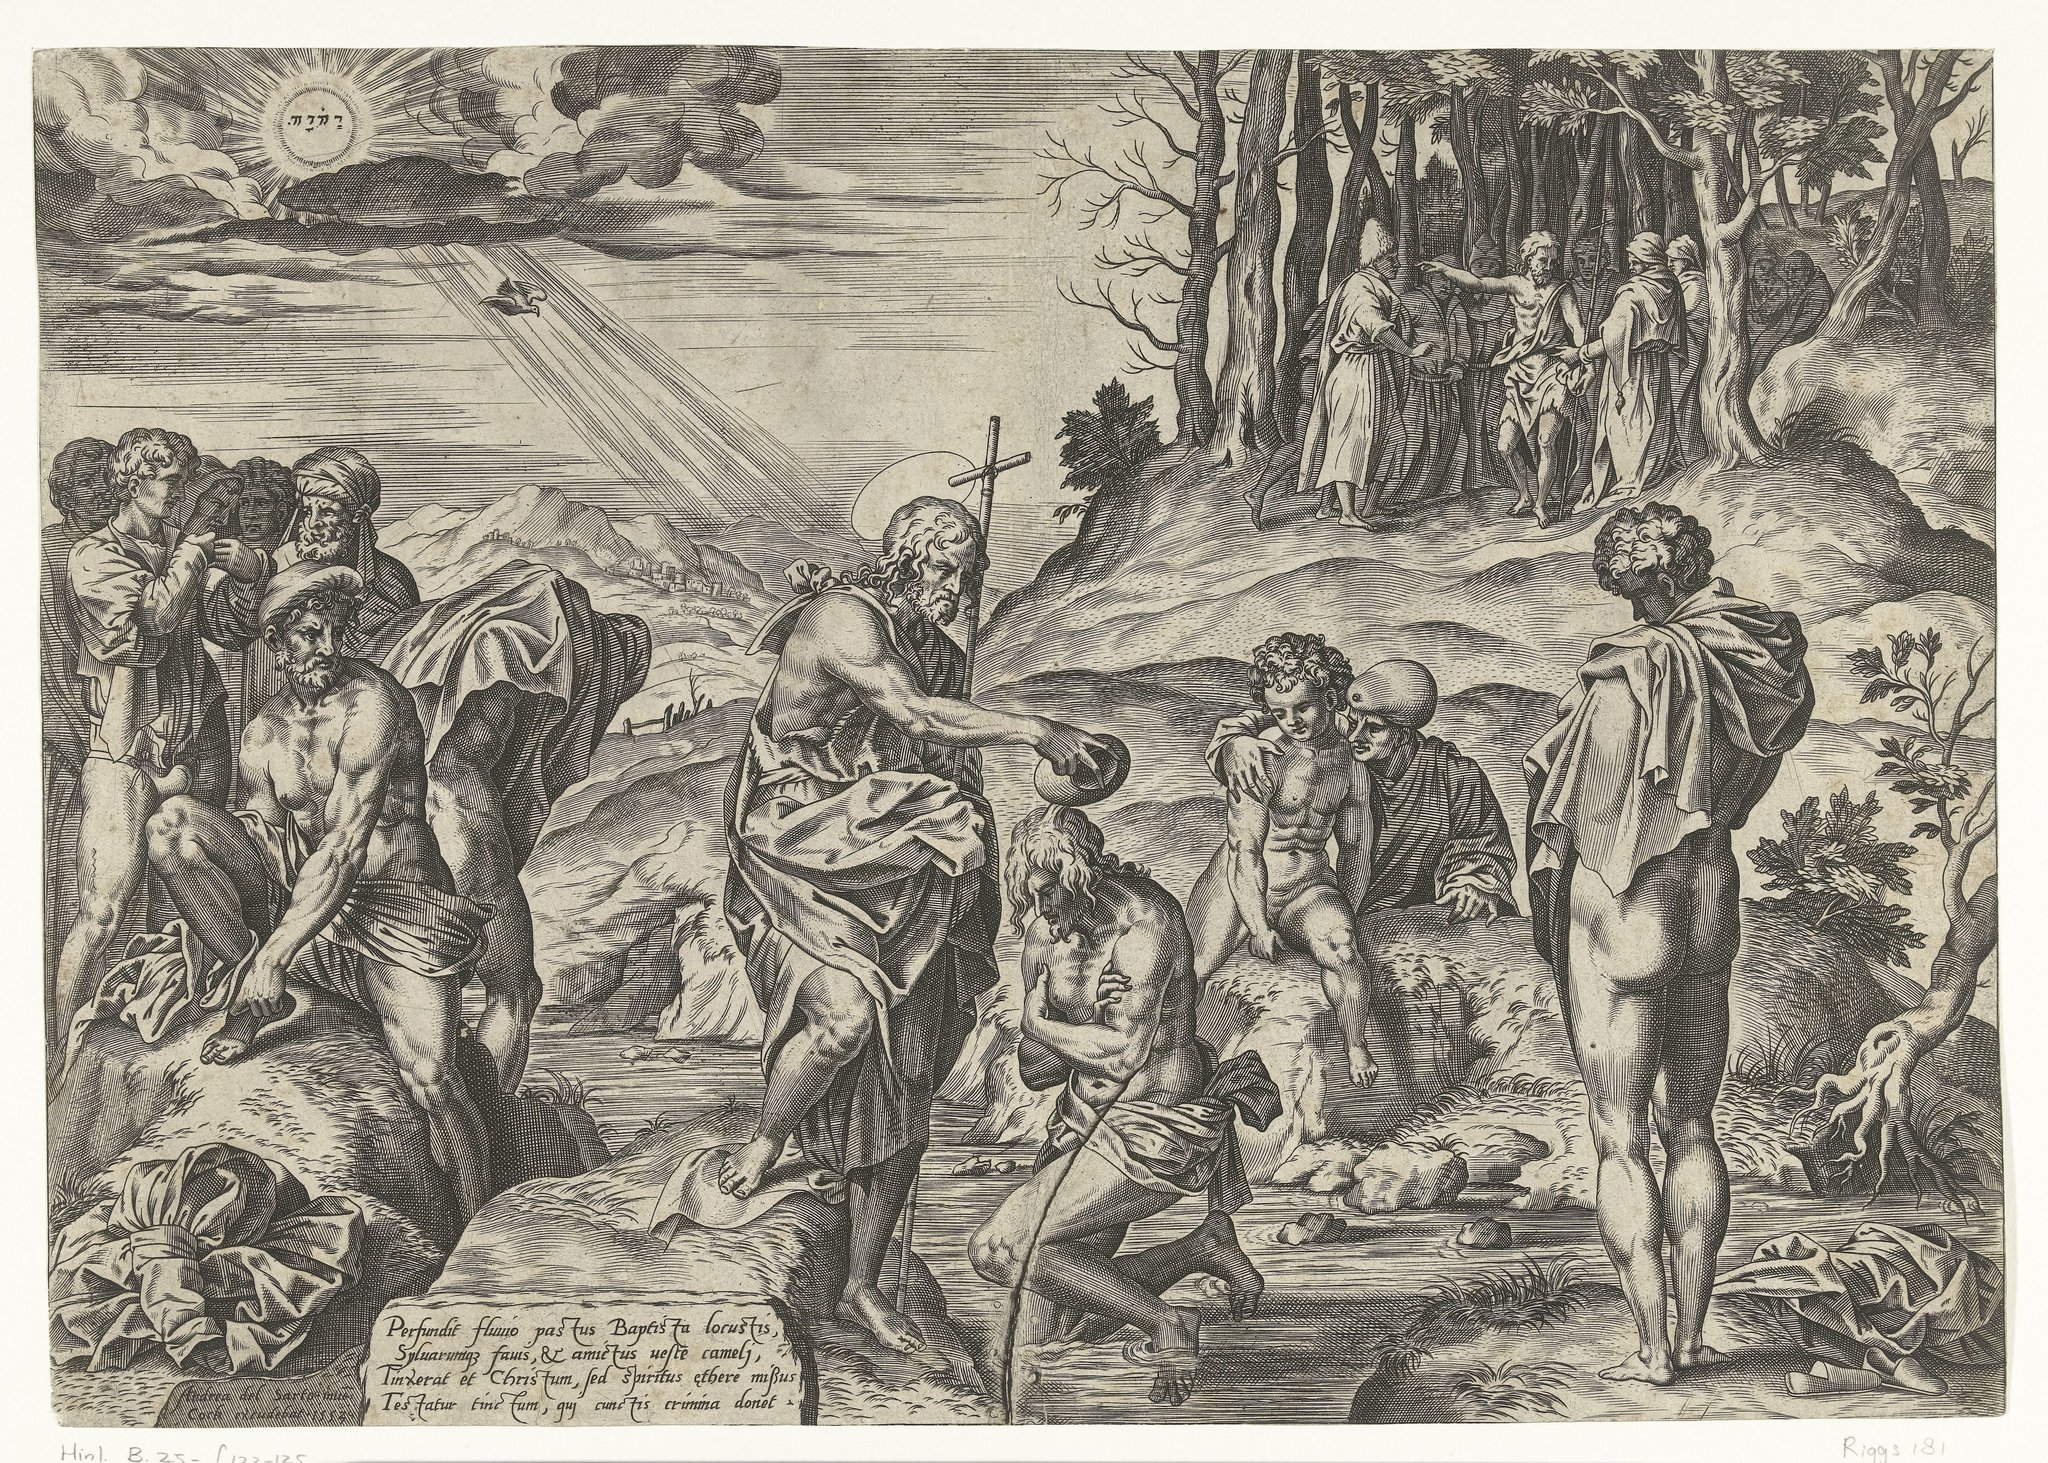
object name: print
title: De doop van Christus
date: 1553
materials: paper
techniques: engraving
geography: antwerp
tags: baptism of christ in the river jordan: john the baptist pouring out water on christ's head: the holy ghost descends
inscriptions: collector's mark: Lugt 10, collector's mark: Lugt 11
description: Johannes de Doper doopt Christus met water uit een beek. De Heilige Geest komt neer op Christus in de gedaante van een duif. Een groep mannen staat in de rij om eveneens door Johannes gedoopt te worden.